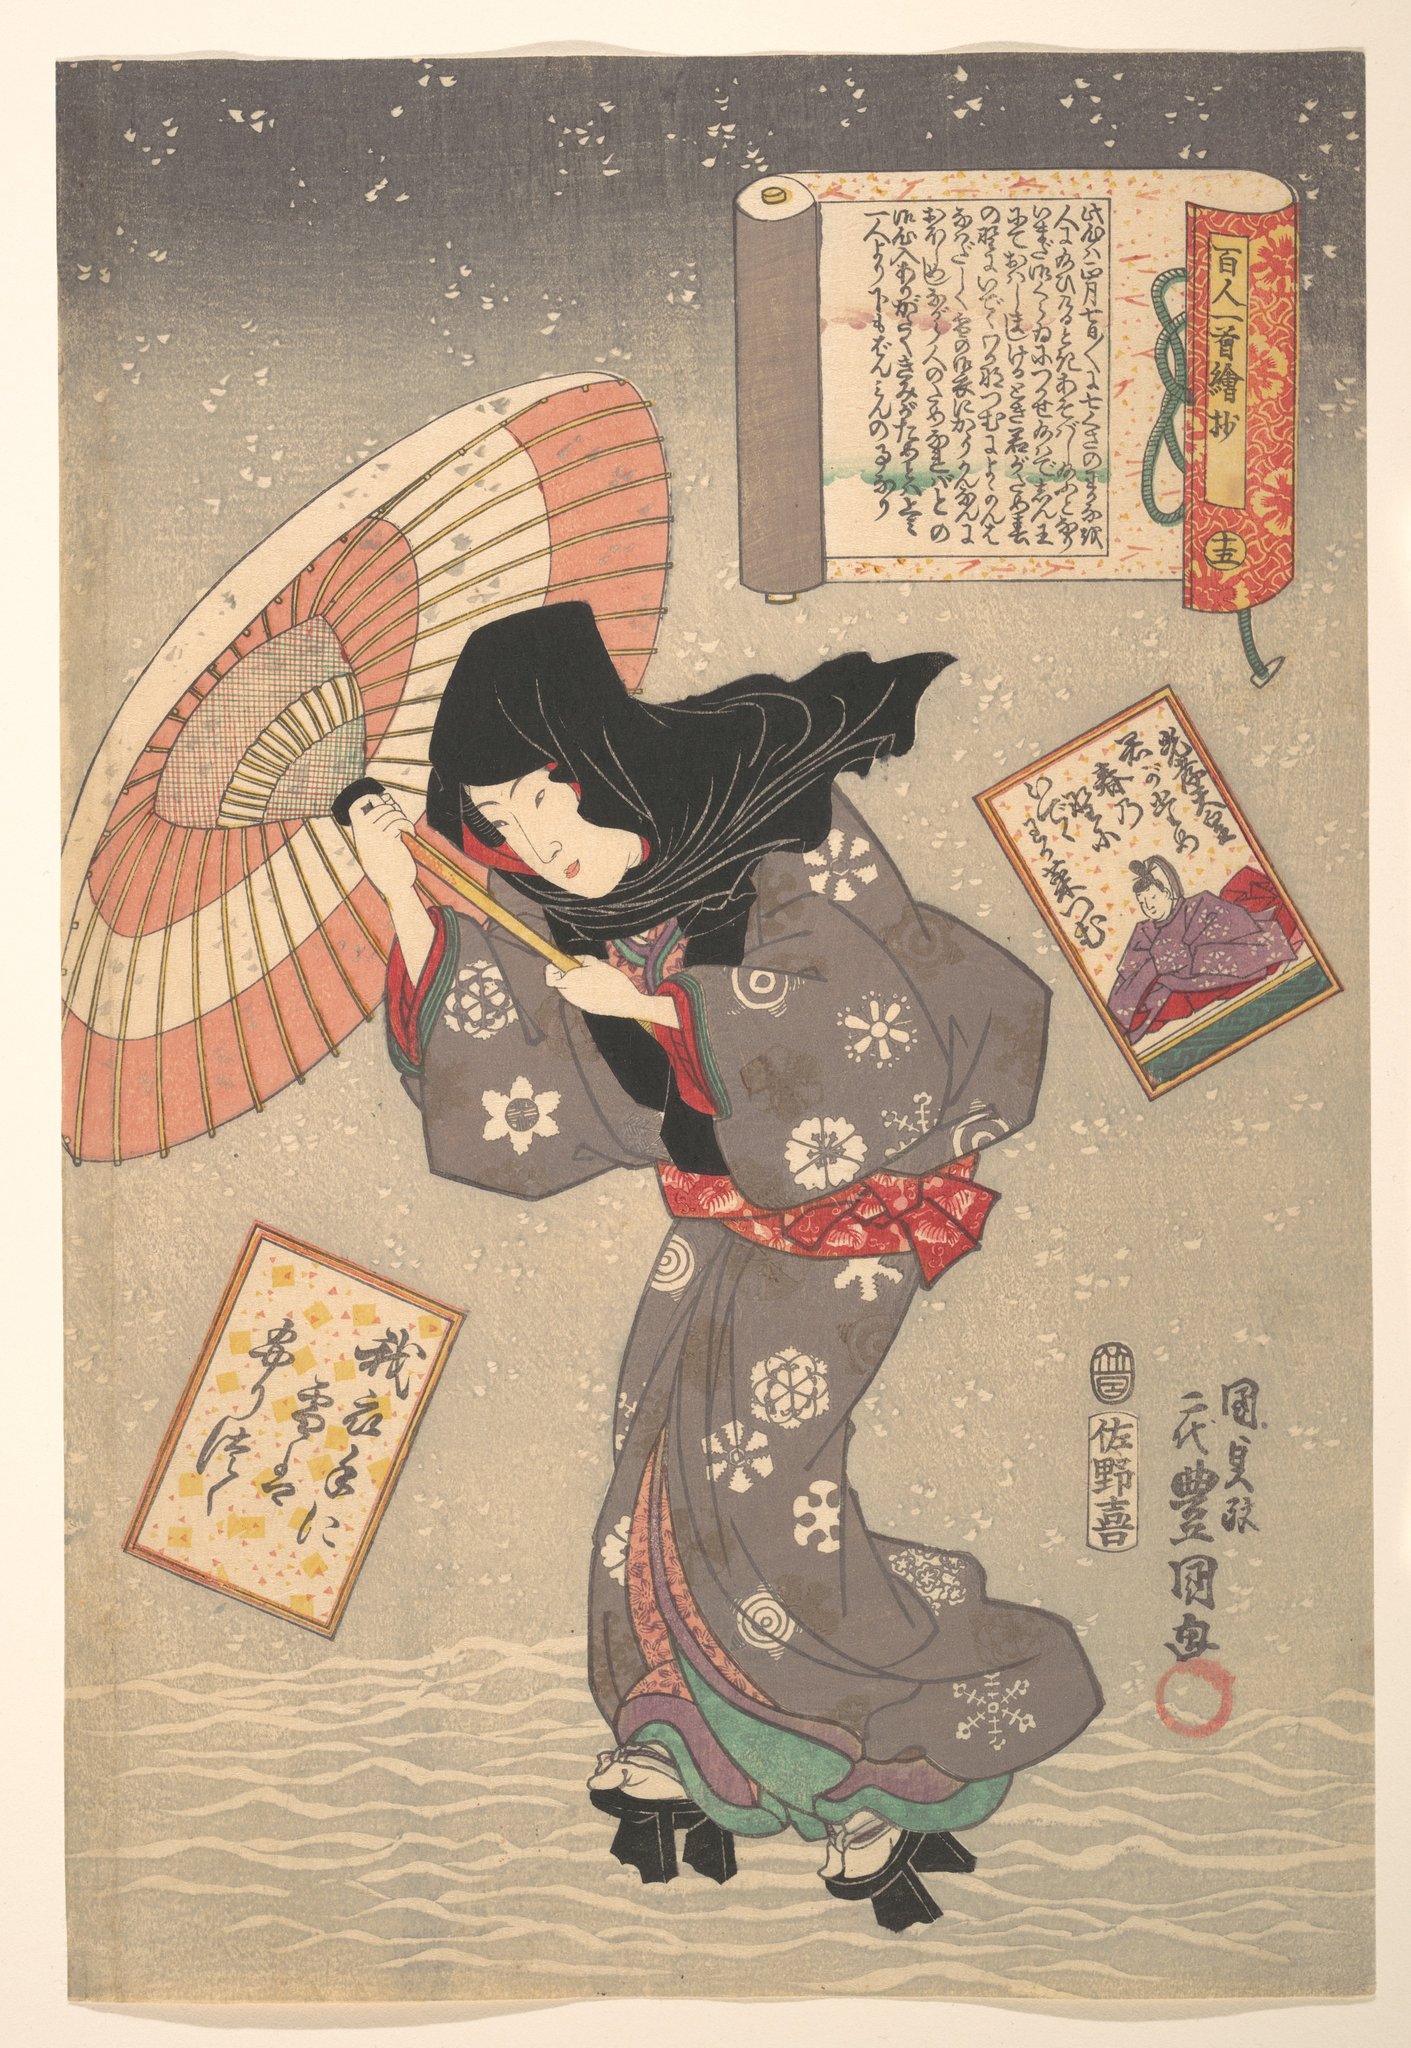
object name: print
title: Selected Scenes from One Poem Each by One Hundred Poets: Poem by Emperor Kōkō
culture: japanese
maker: utagawa kunisada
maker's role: artist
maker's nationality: japanese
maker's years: 1786-1864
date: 1801-1900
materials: ink, paper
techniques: woodblock print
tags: poetry,women